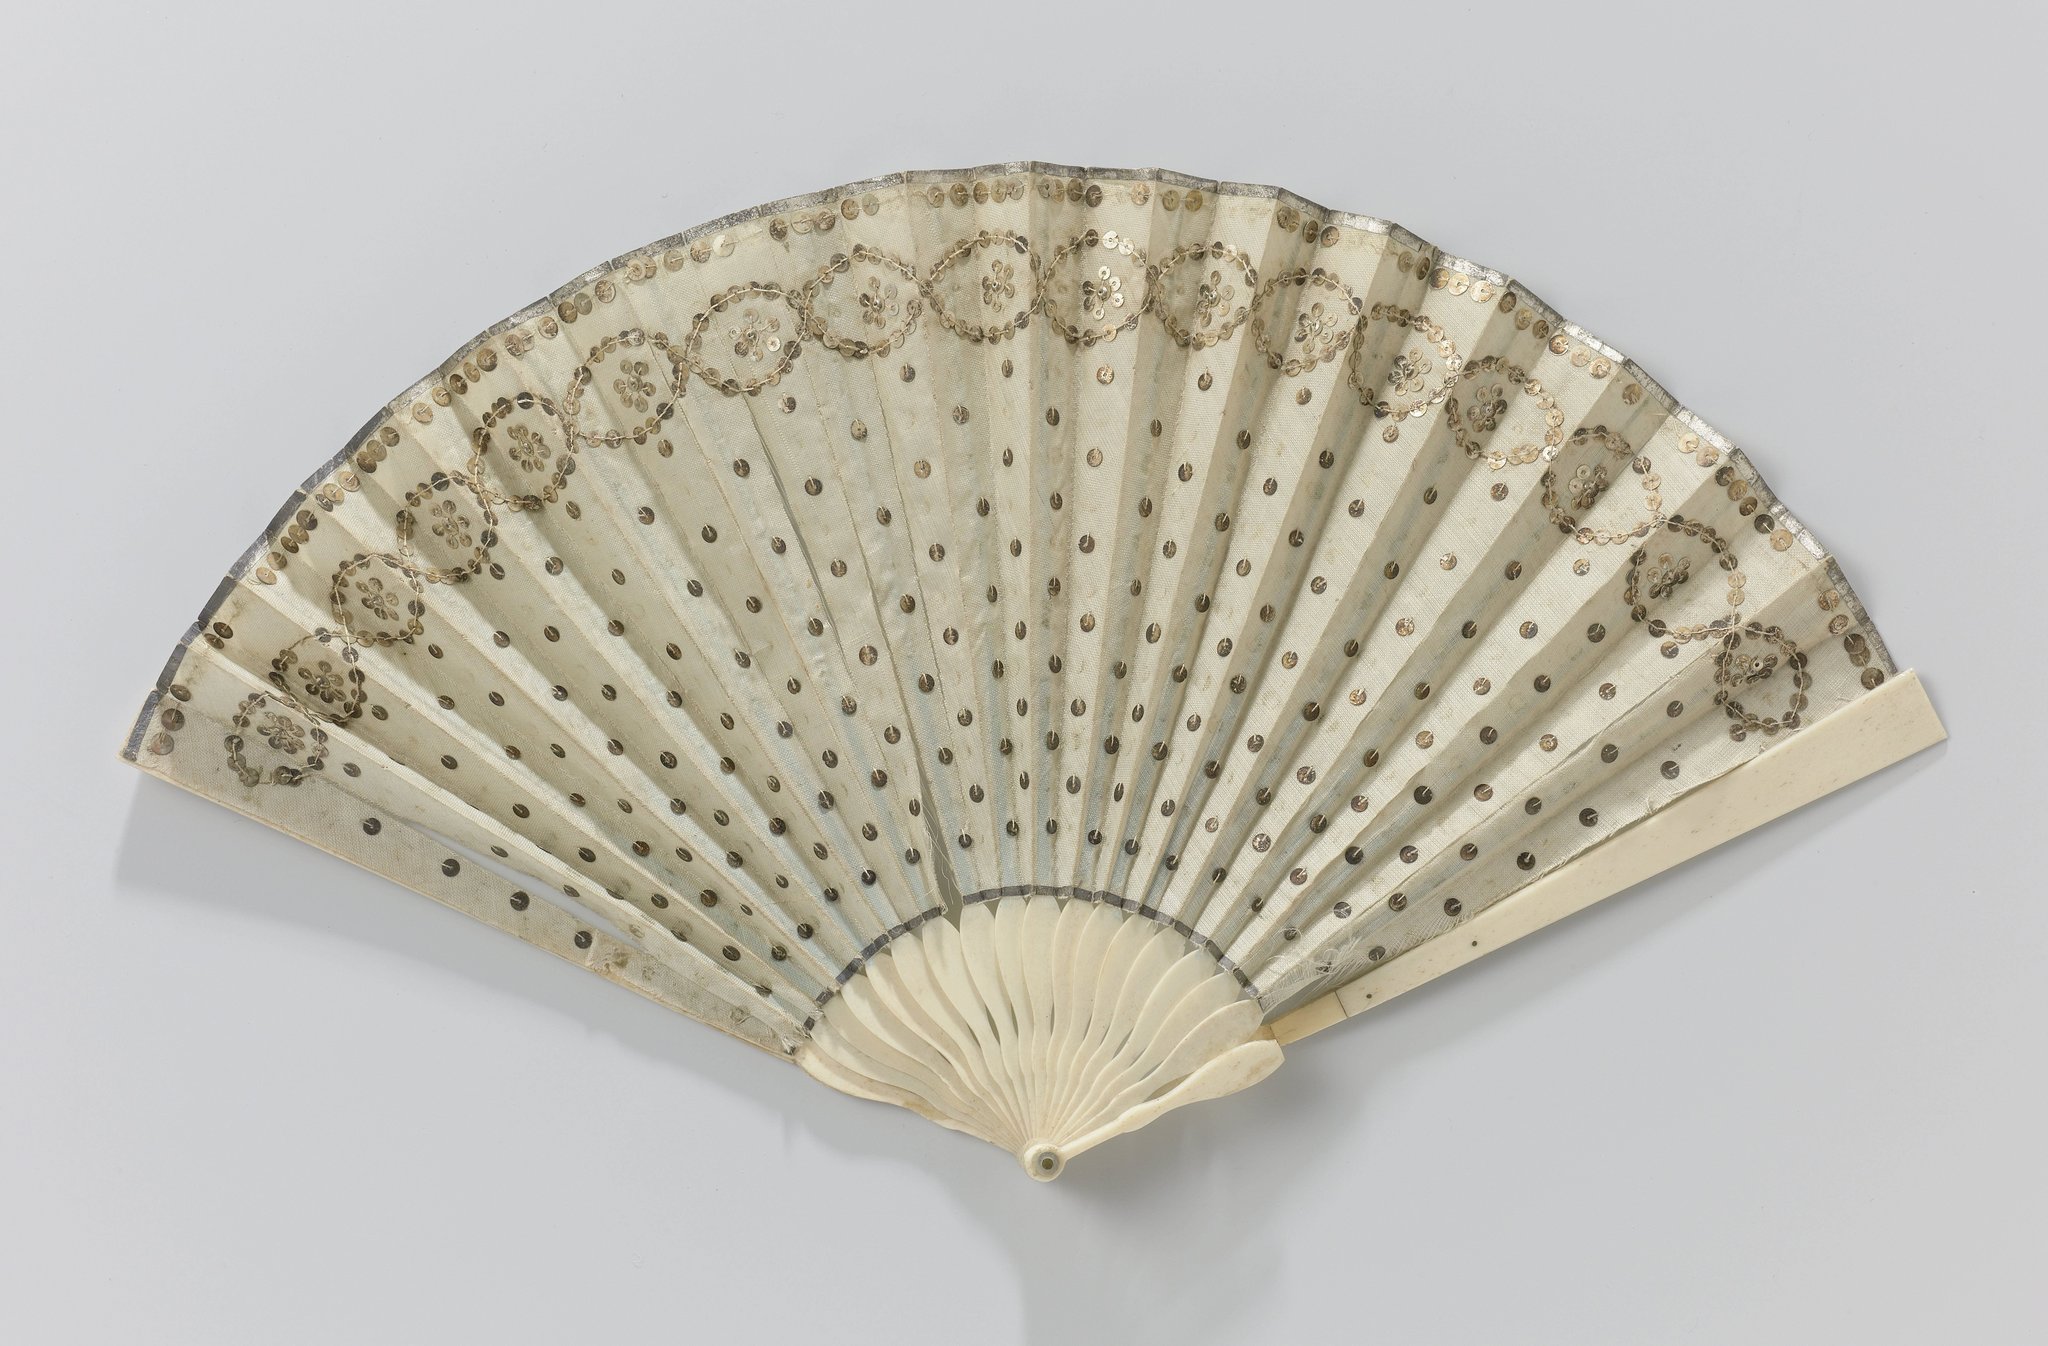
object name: vouwwaaier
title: Vouwwaaier met blad van cremekleurige zijde met goudkleurige lovers, montuur van ivoor (?)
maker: Anonymous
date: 1800-1849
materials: copper, ivory, mother of pearl, sequin, silk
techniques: cutting, sewing, weave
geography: netherlands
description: Vouwwaaier met blad van cremekleurige zijde met goudkleurige lovers in symmetrisch motief; tegen de bovenrand in de vorm van aaneengeschakelde ovalen met rozetten in het midden van lovers, lovers regelmatig gestrooid over het overige blad, bovenrand van blad van zilverpapier. Het montuur heeft 18 aaneengesloten benen, is van ivoor(?) en is onversierd. Sluitpin van koper met ring van parelmoer.